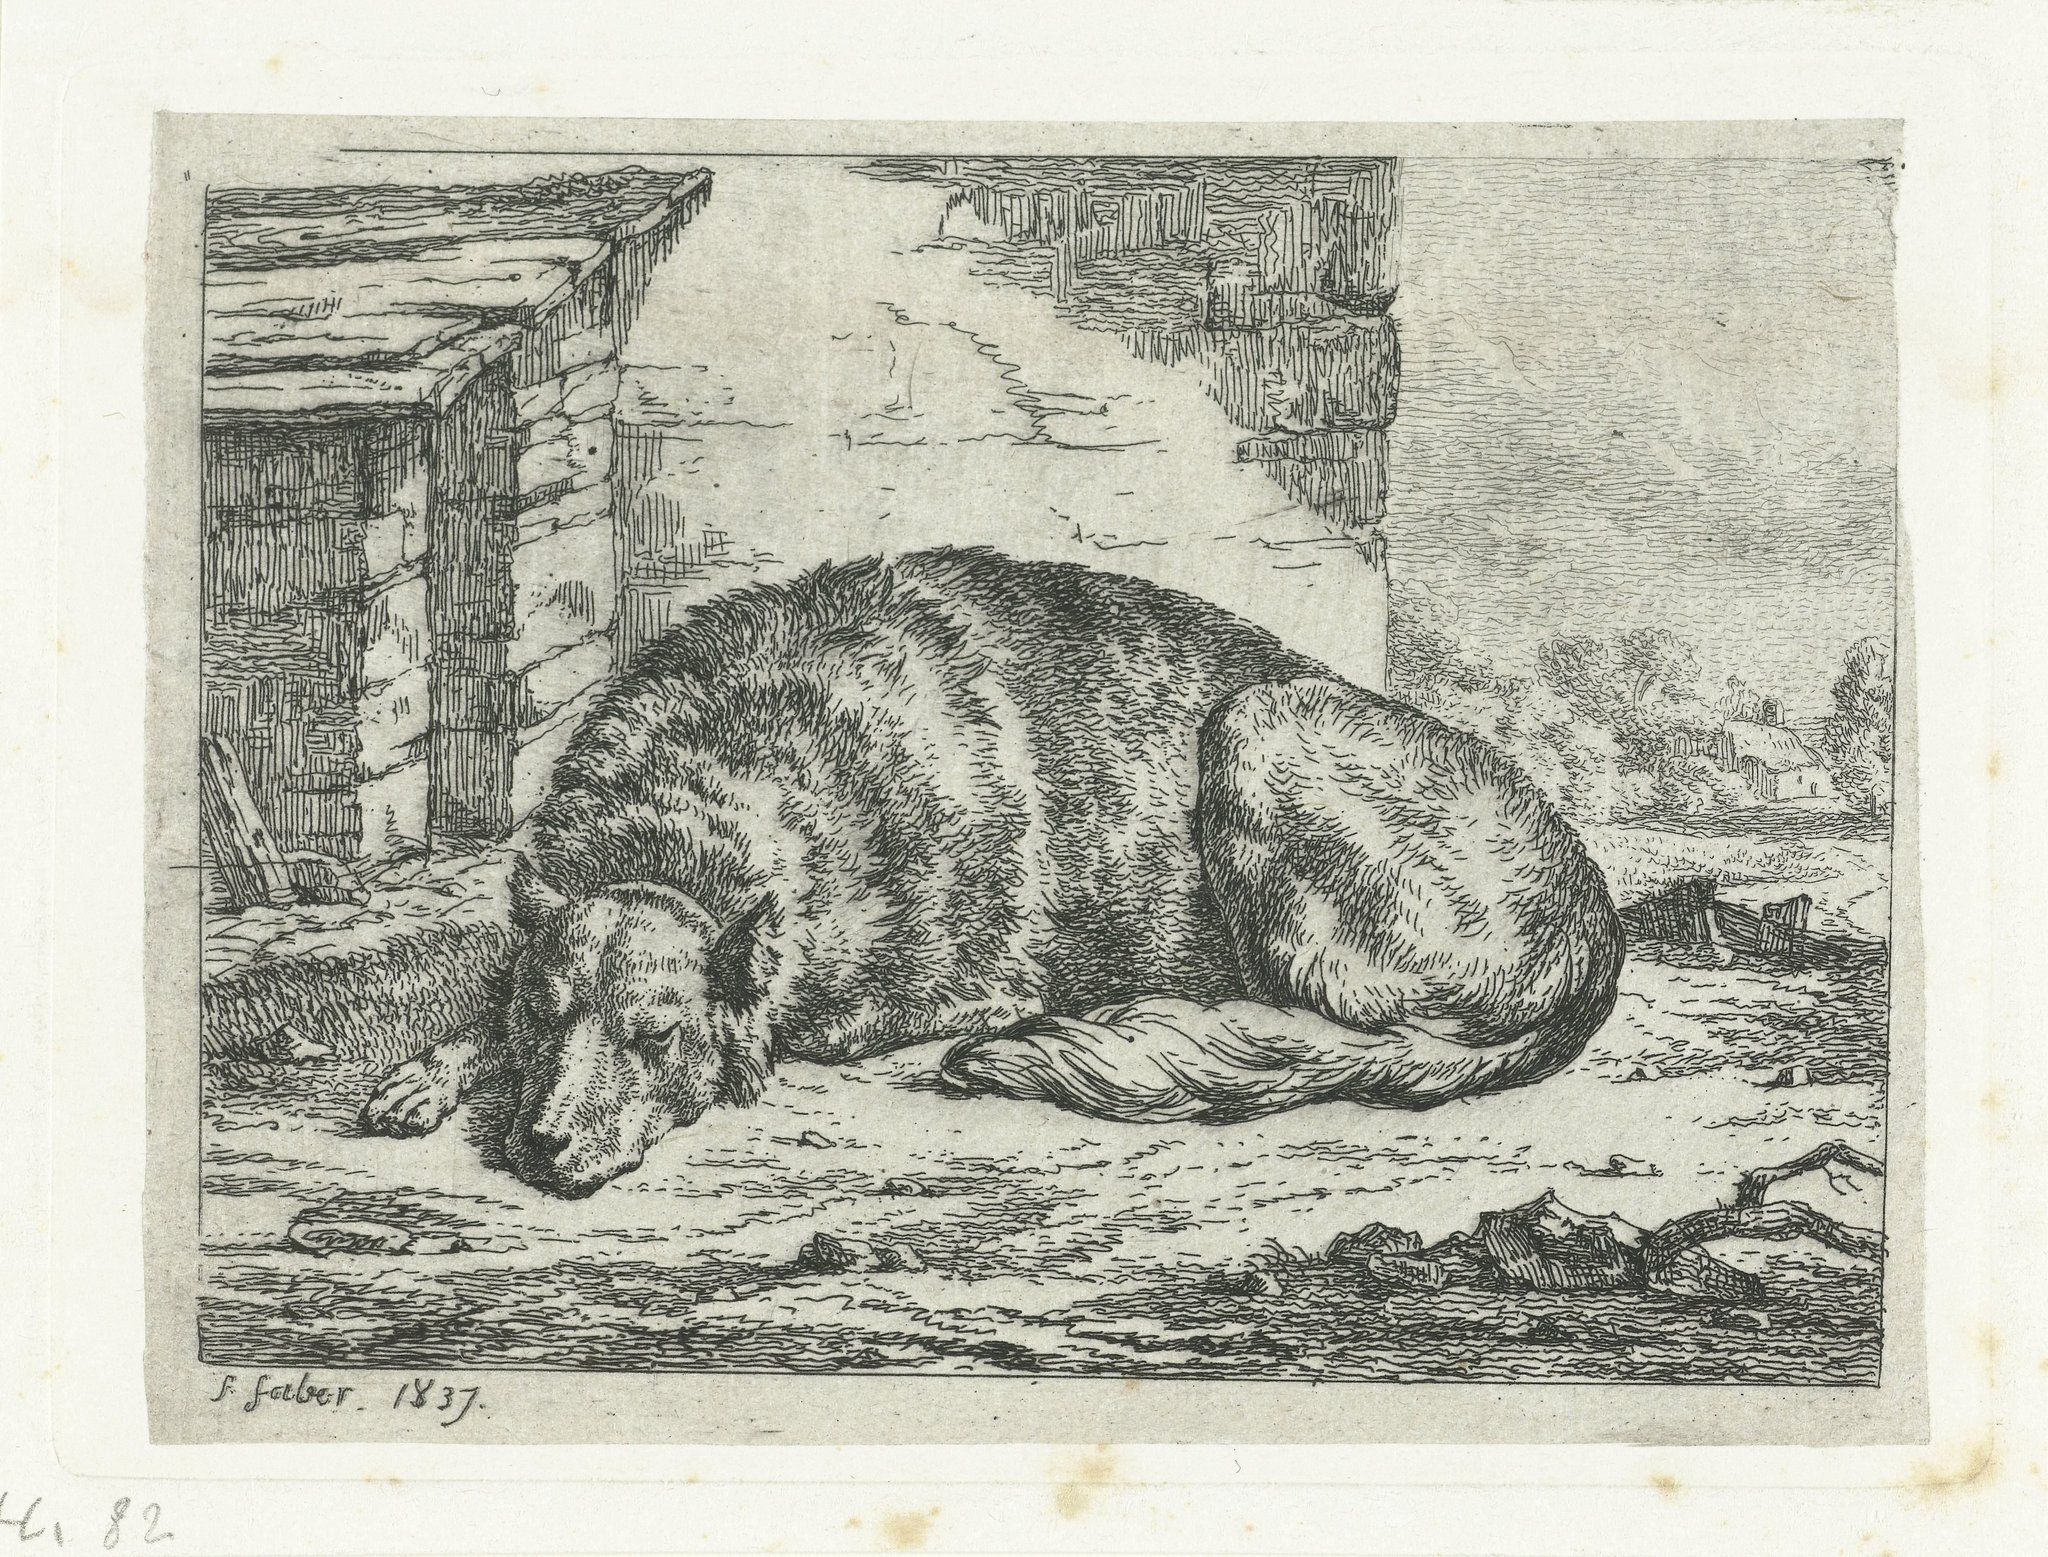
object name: print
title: Slapende hond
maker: frédéric théodore faber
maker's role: print maker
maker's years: 1782-1844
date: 1837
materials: paper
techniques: etching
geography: brussels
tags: dog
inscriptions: collector's mark: Lugt 2228, collector's mark: Lugt 1485